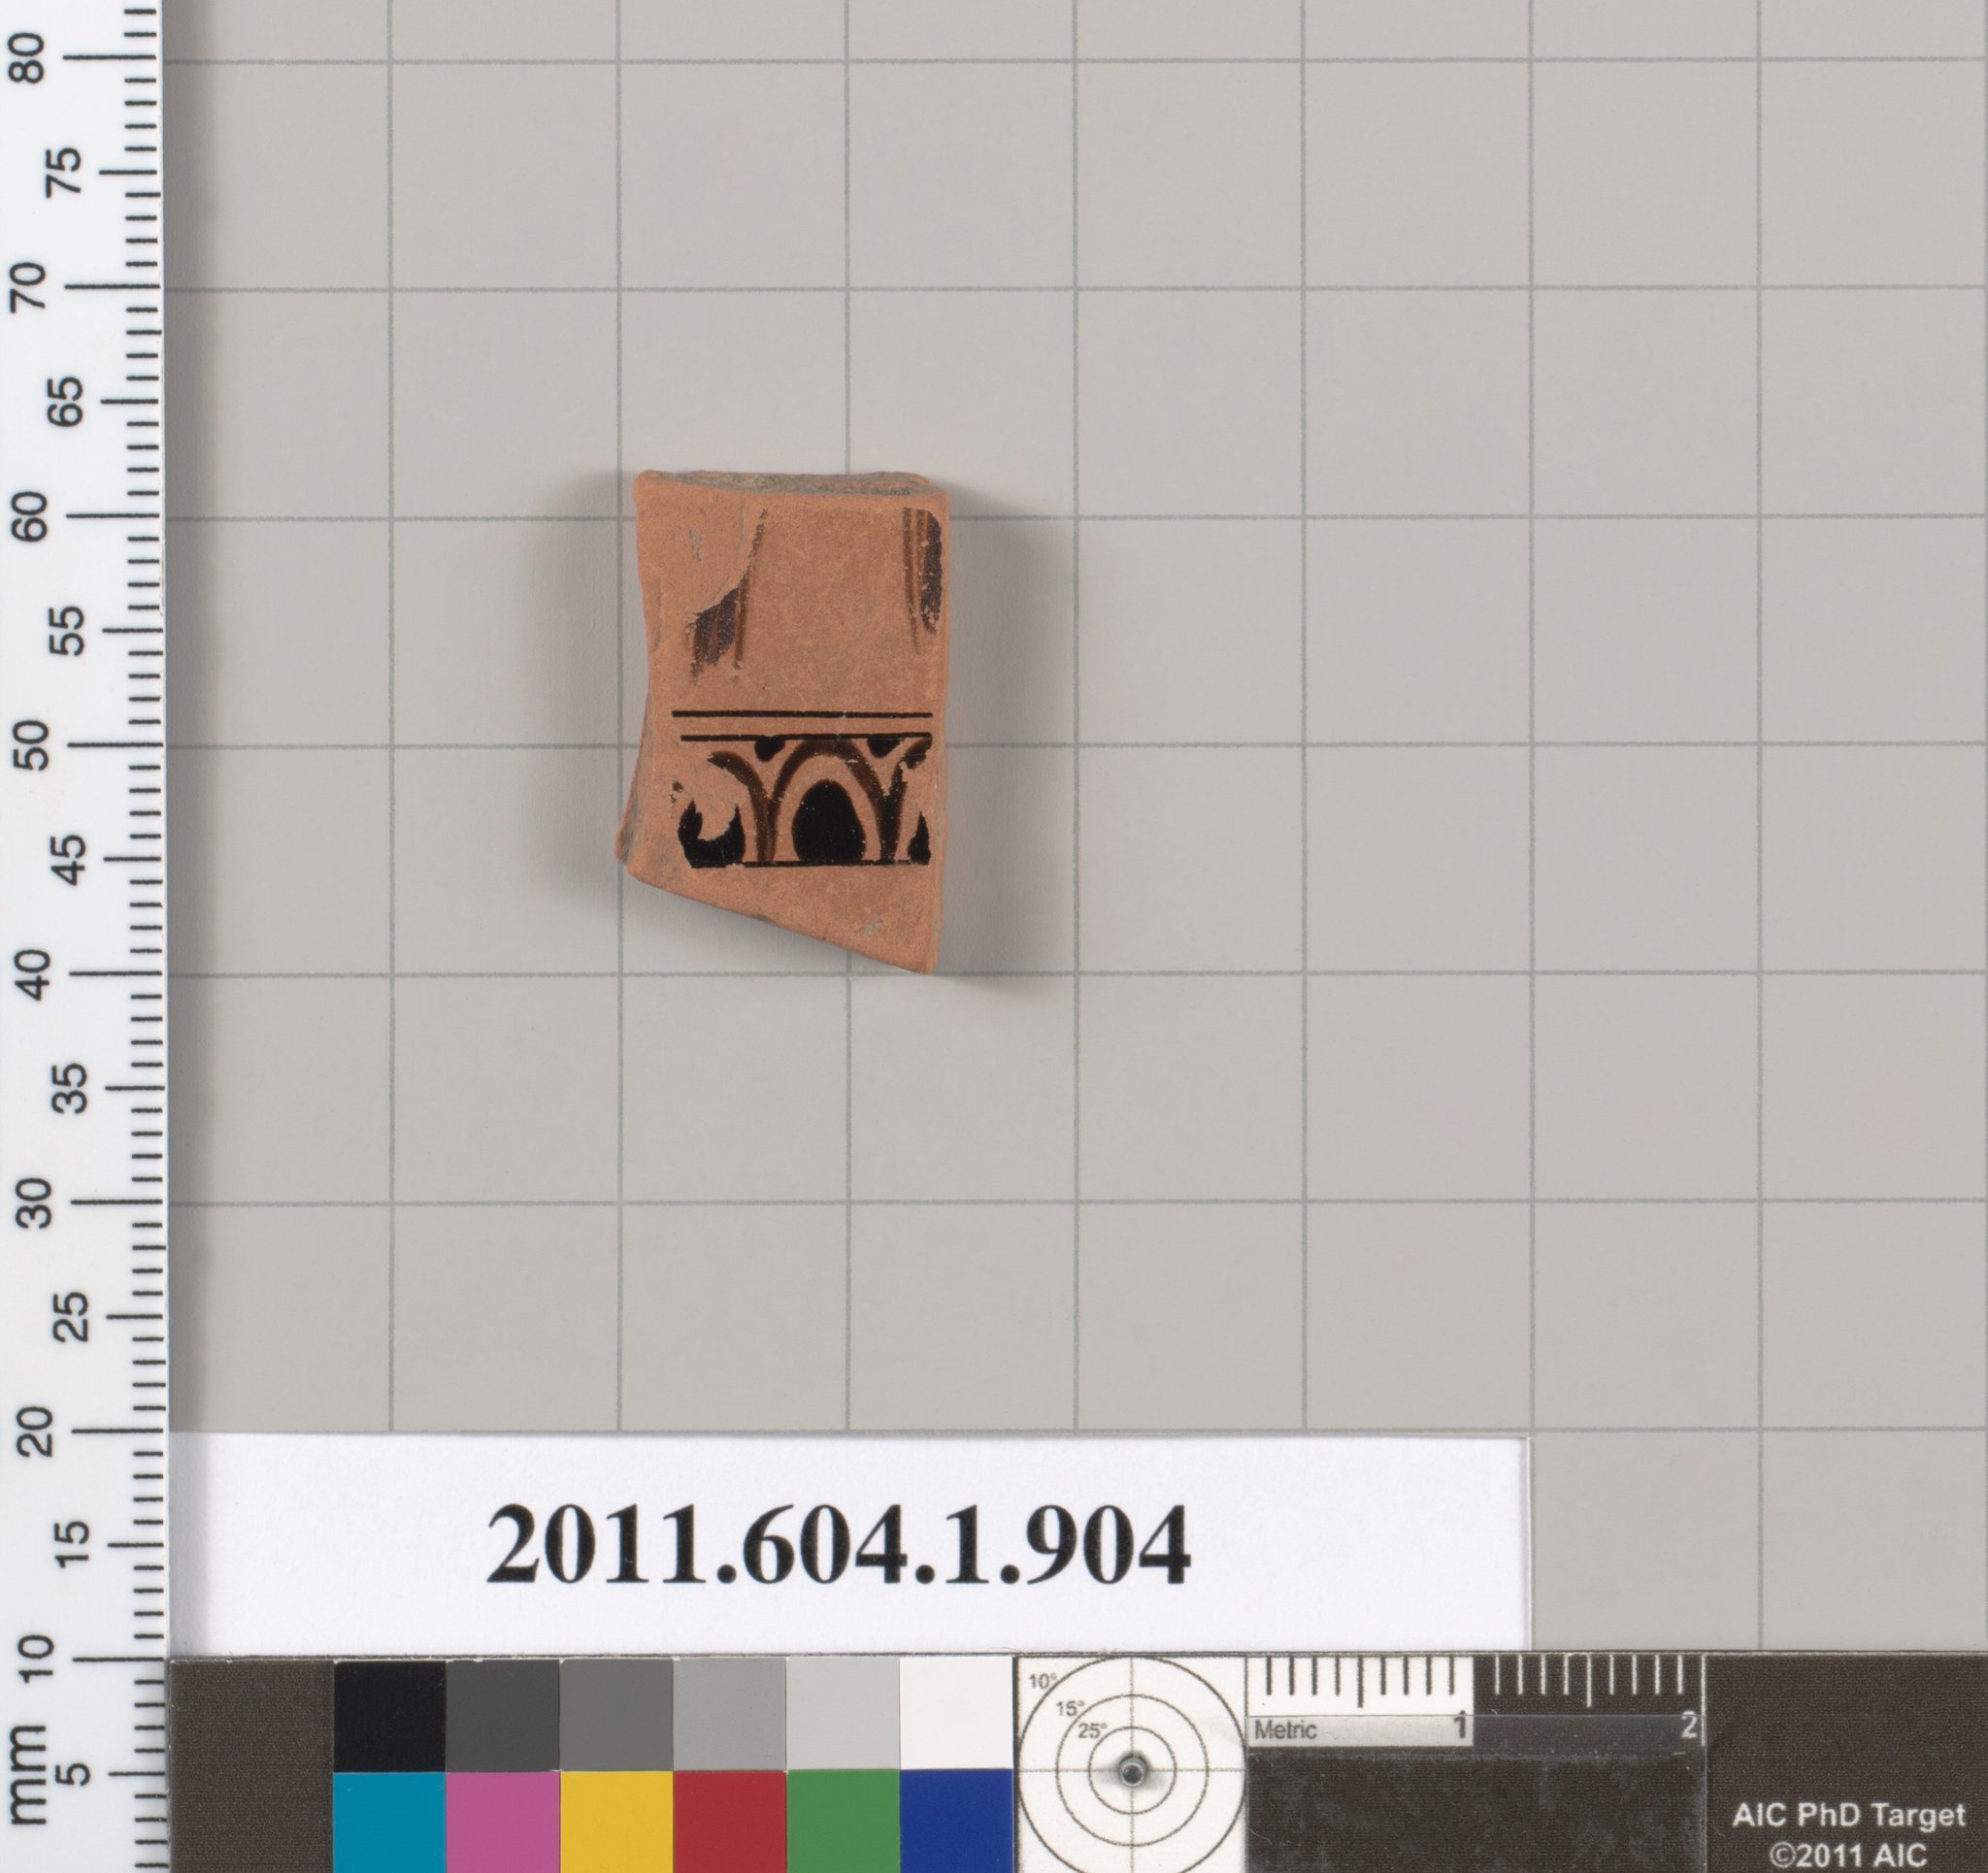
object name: kylix fragment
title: Terracotta fragment of a kylix (drinking cup)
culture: greek, attic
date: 475-451 BCE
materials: terracotta